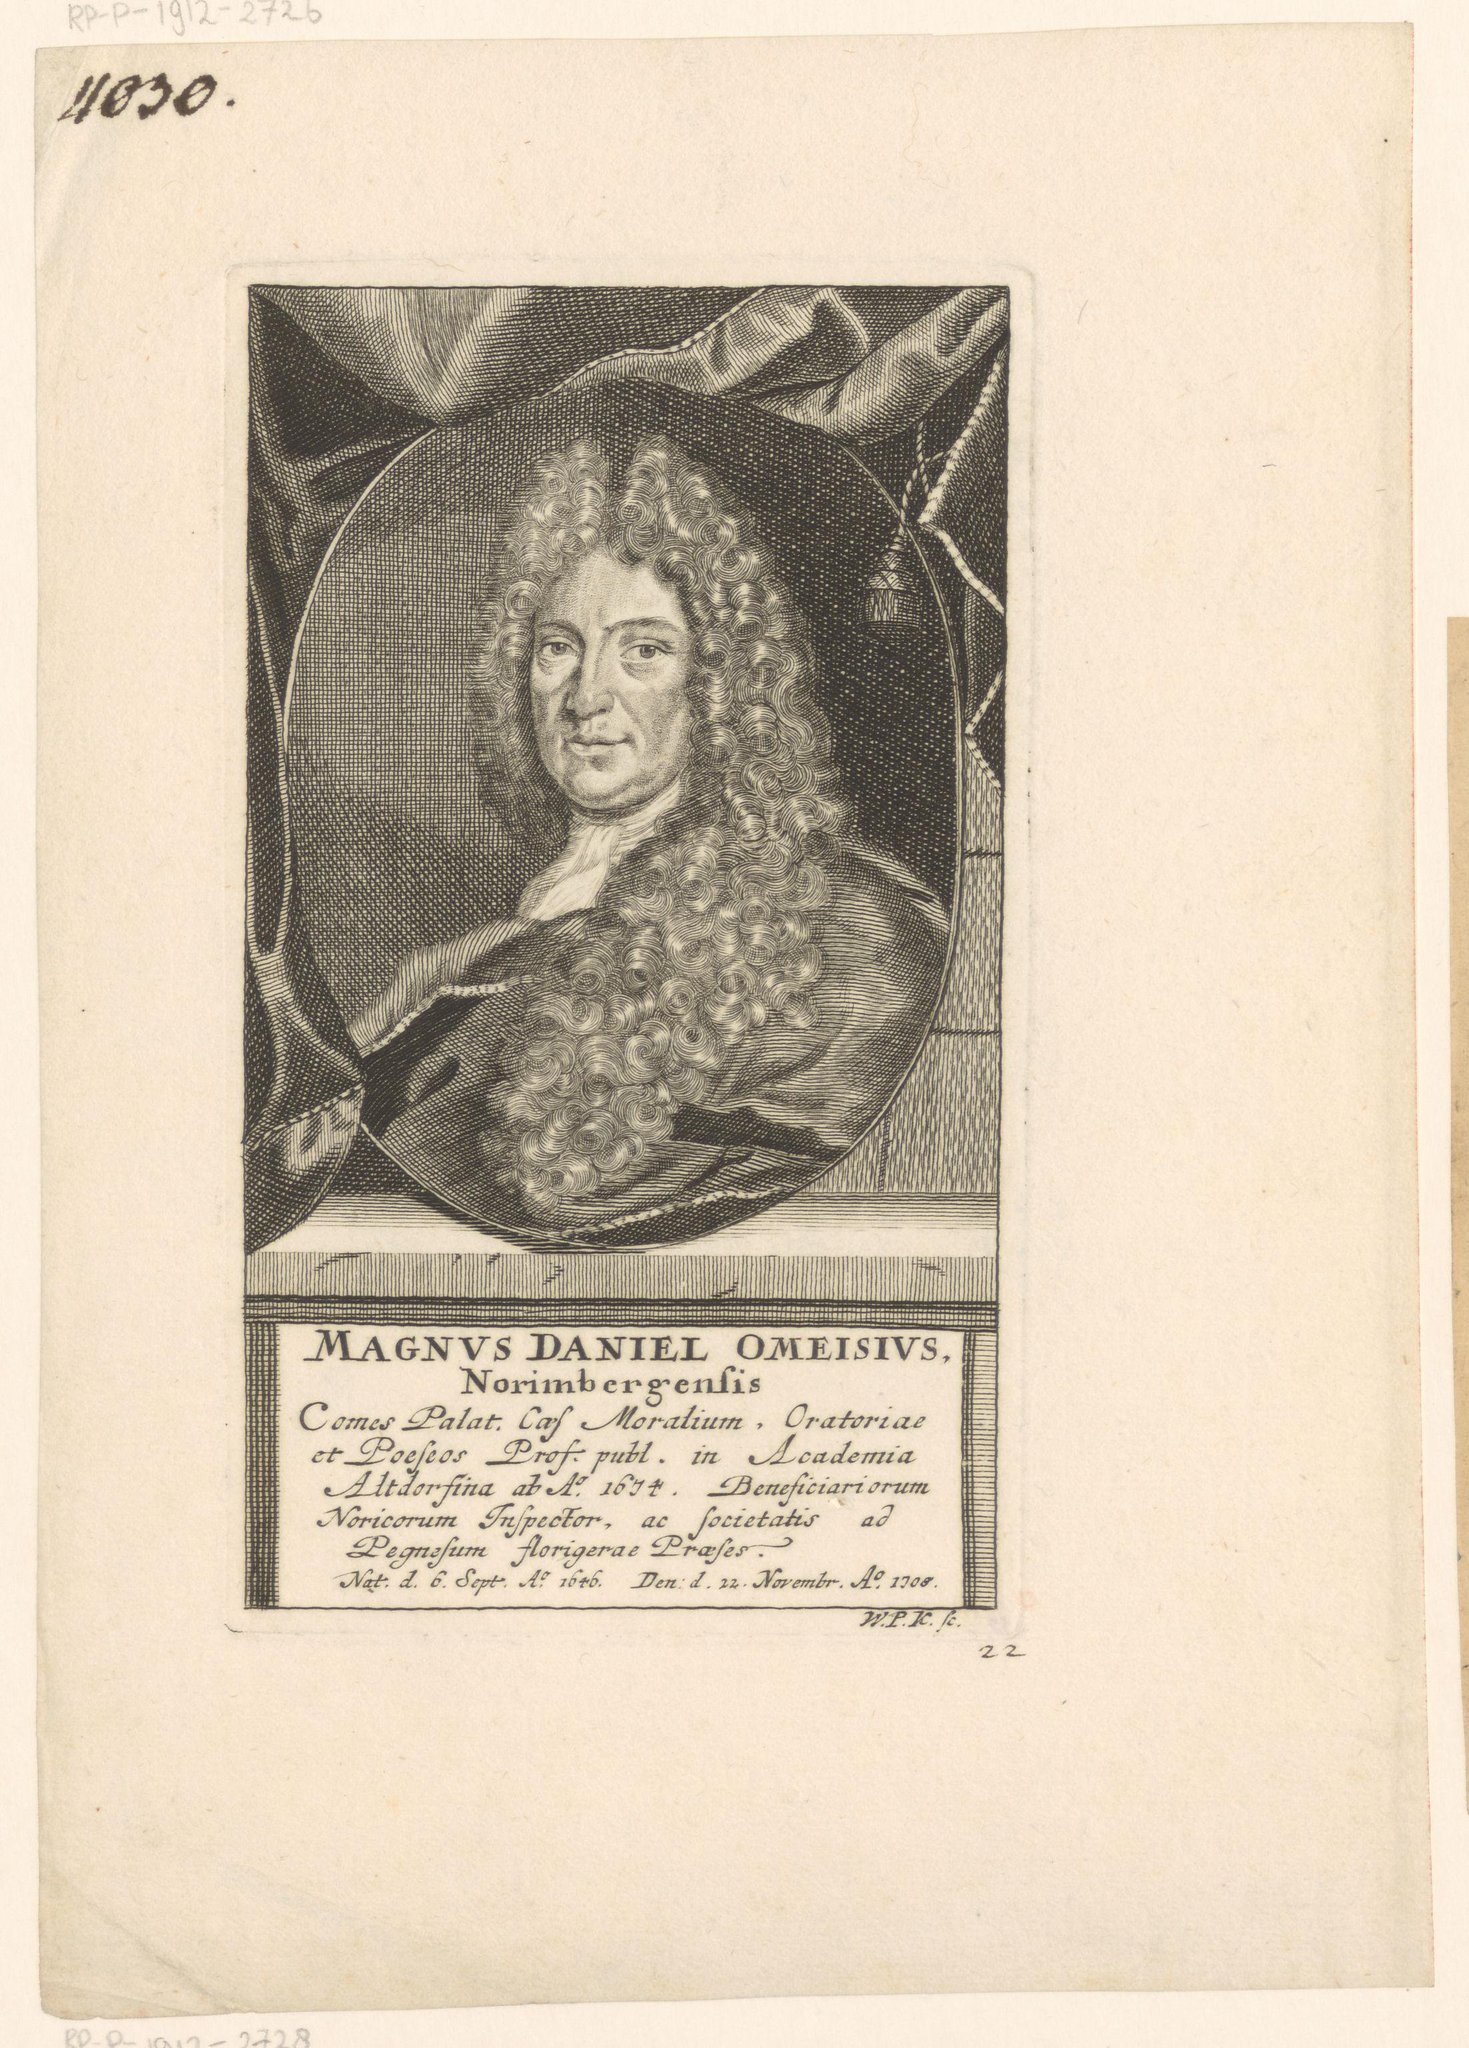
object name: print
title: Portret van Magnus Daniel Omeis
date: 1708-1728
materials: paper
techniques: engraving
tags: magnus daniel omeis, history and archaeology (+ portrait of scholar, scientist), further education (+ portrait of teacher, professor), historical persons, portrait of a writer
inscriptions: number: ‘22’, collector's mark: Lugt 2228